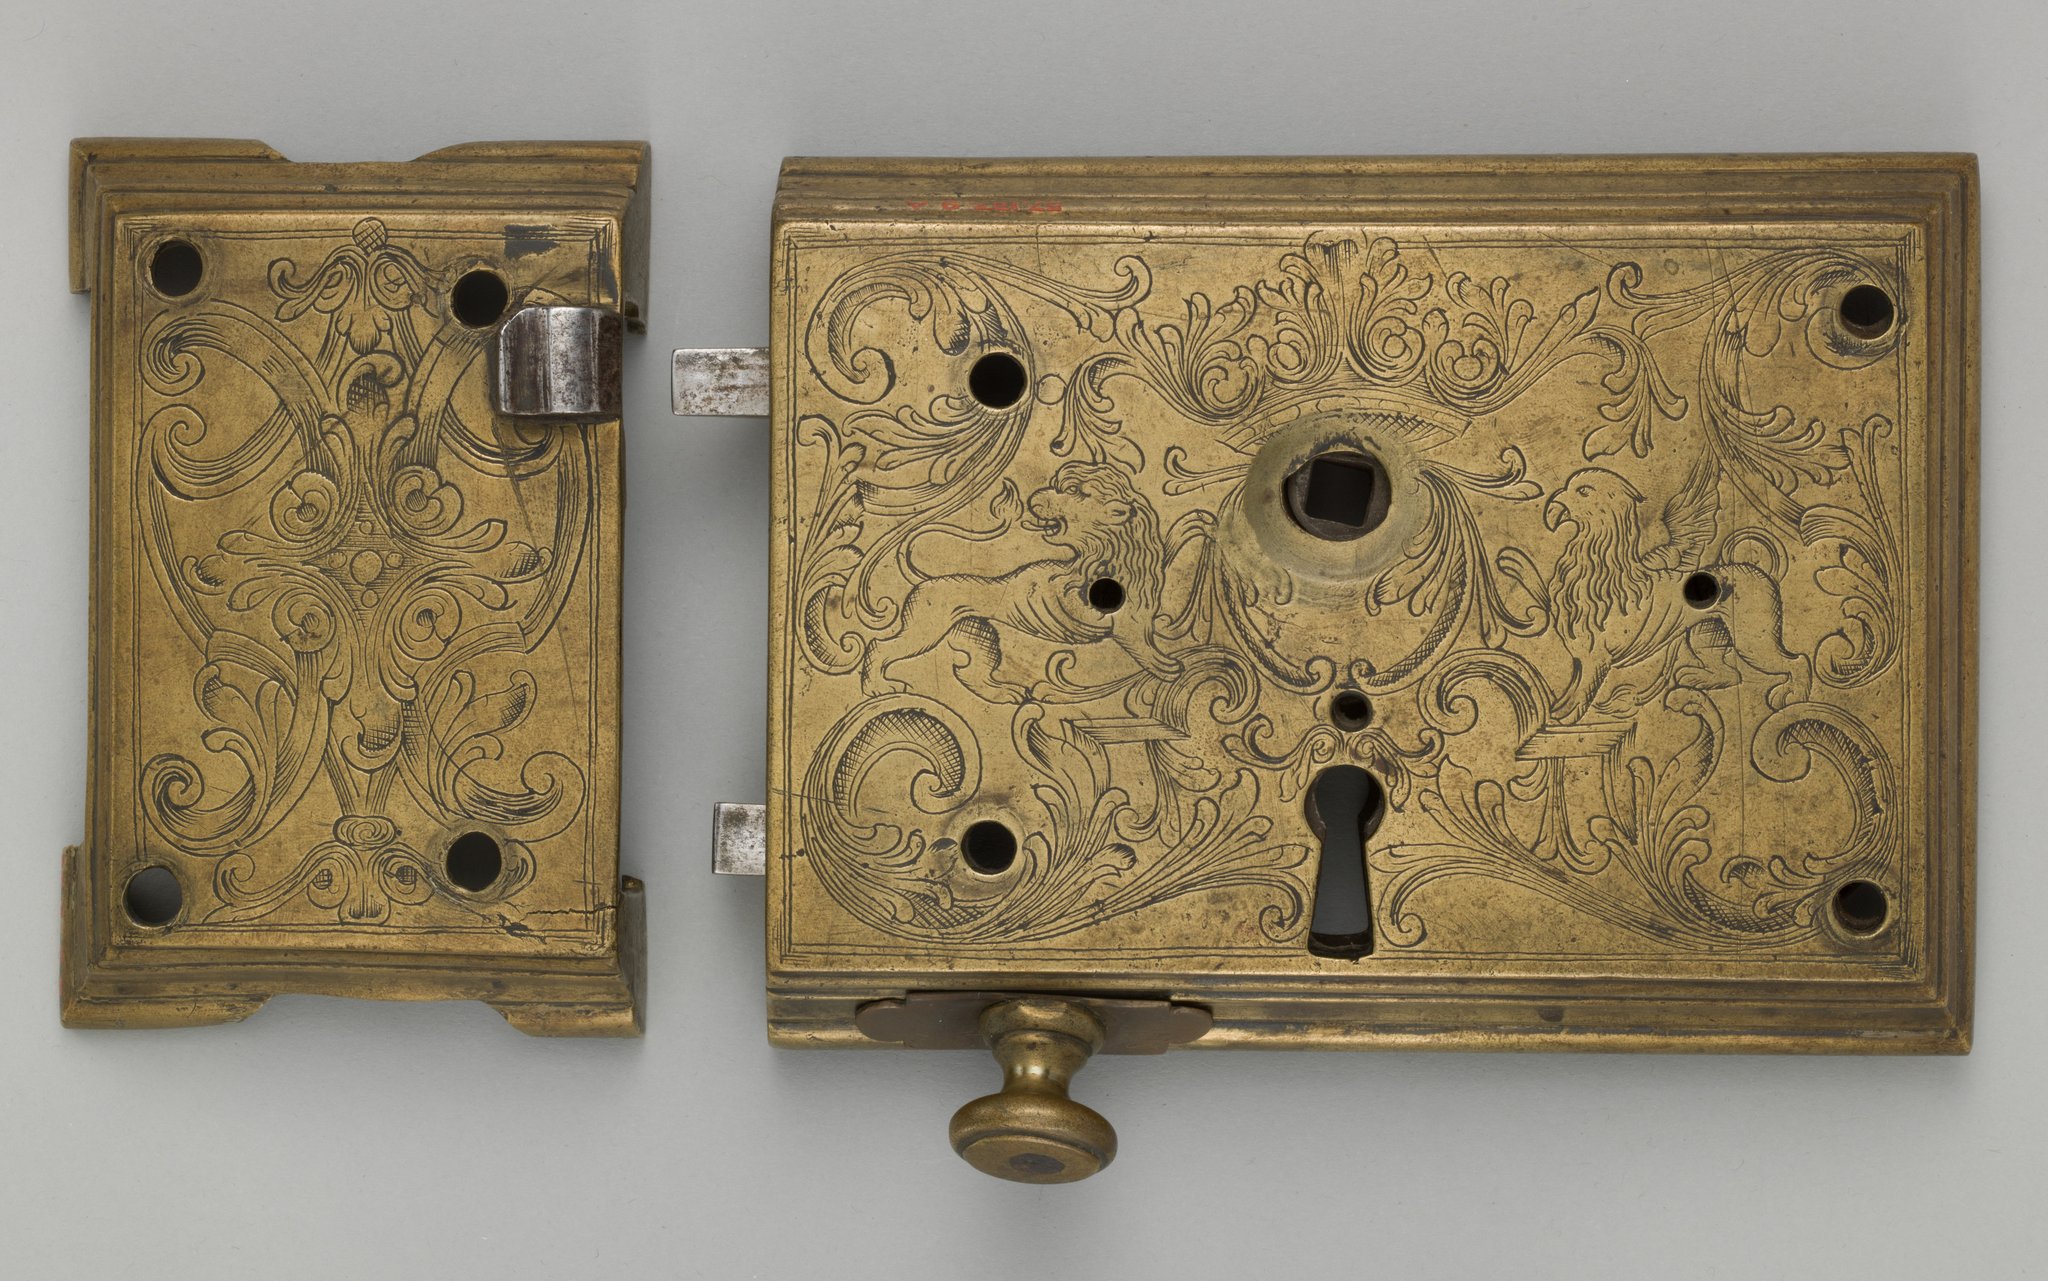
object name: lock and keeper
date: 1701-1800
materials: brass, iron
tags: griffins,lions